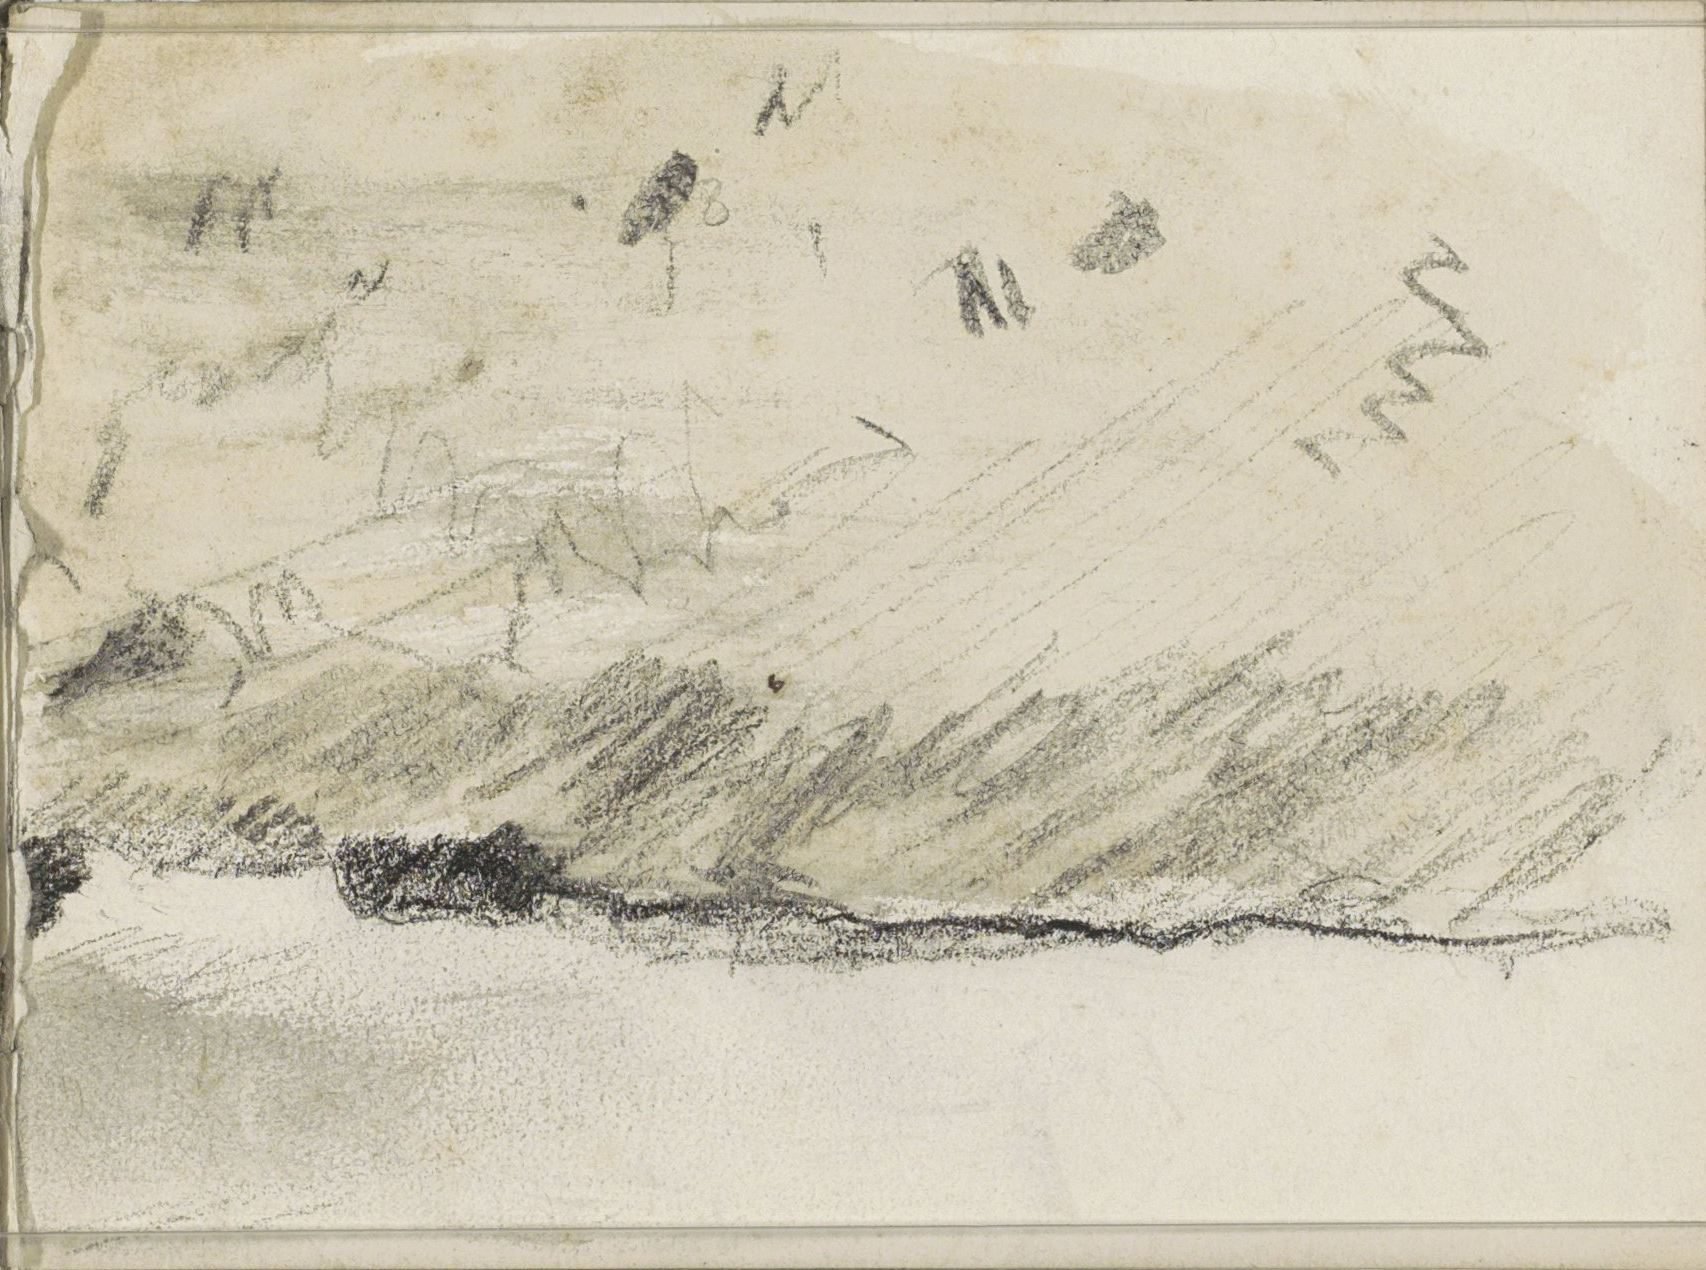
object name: sketchbook leaf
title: Landschap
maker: anton mauve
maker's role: draughtsman, painter, print maker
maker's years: 1838-1888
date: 1881-1888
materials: chalk, paper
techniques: brush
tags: landscapes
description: Blad 13 recto uit een schetsboek met 29 bladen.